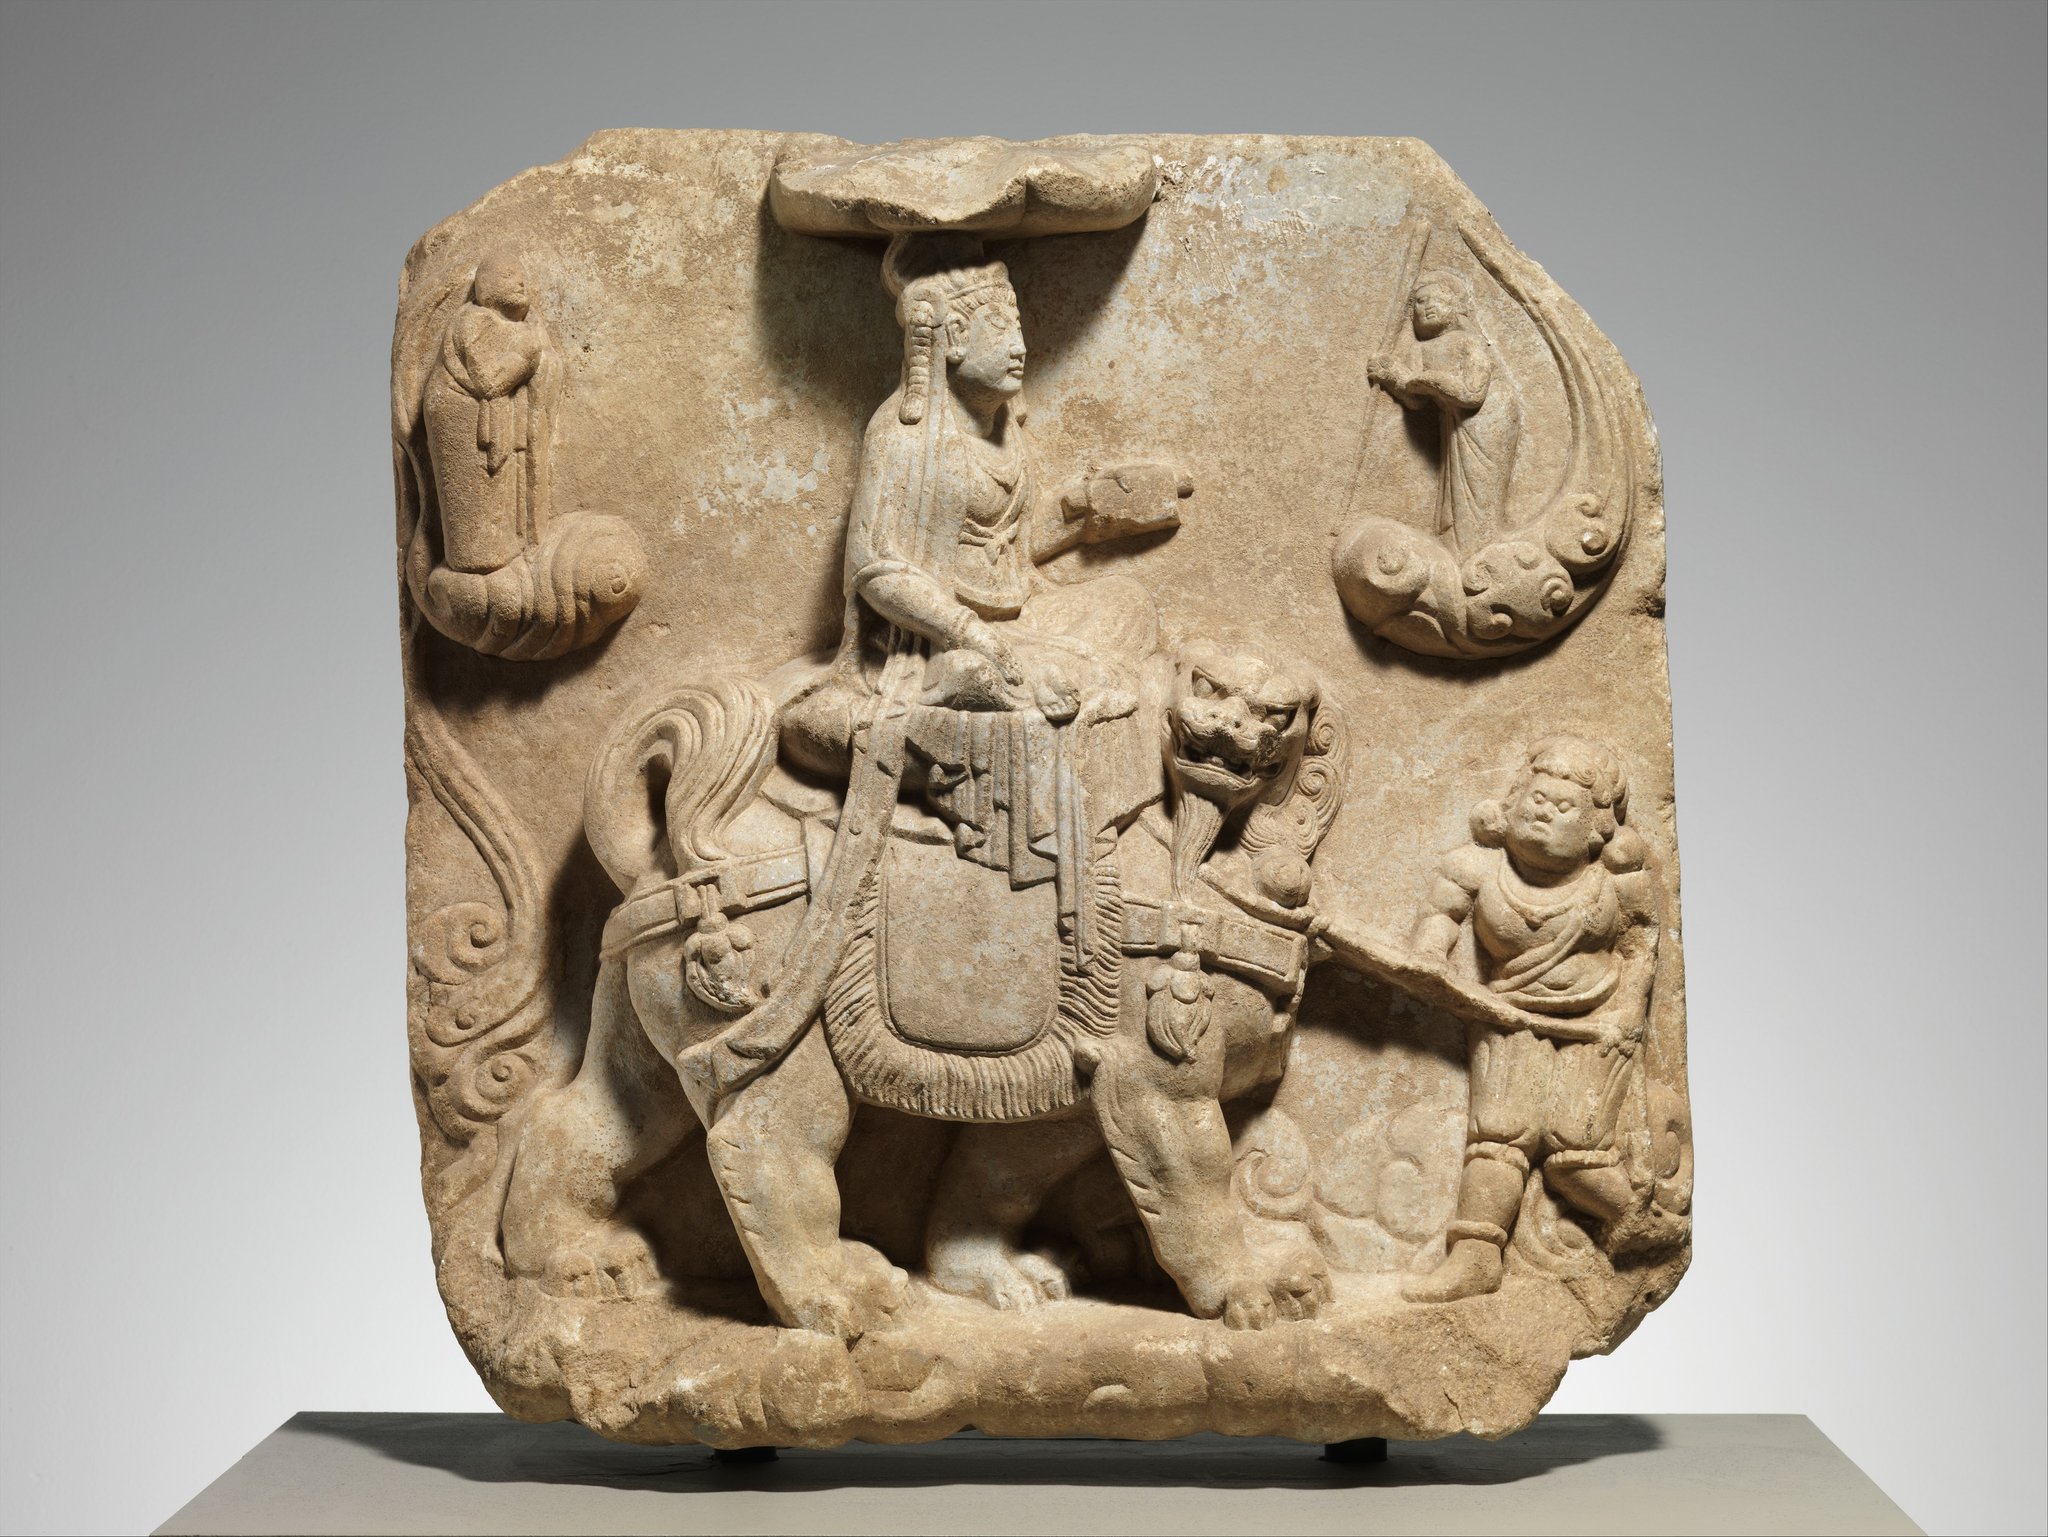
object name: stele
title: Bodhisattva Manjushri with attendants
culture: chinese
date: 1001-1100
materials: marble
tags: men,lions,buddhism,manjushri